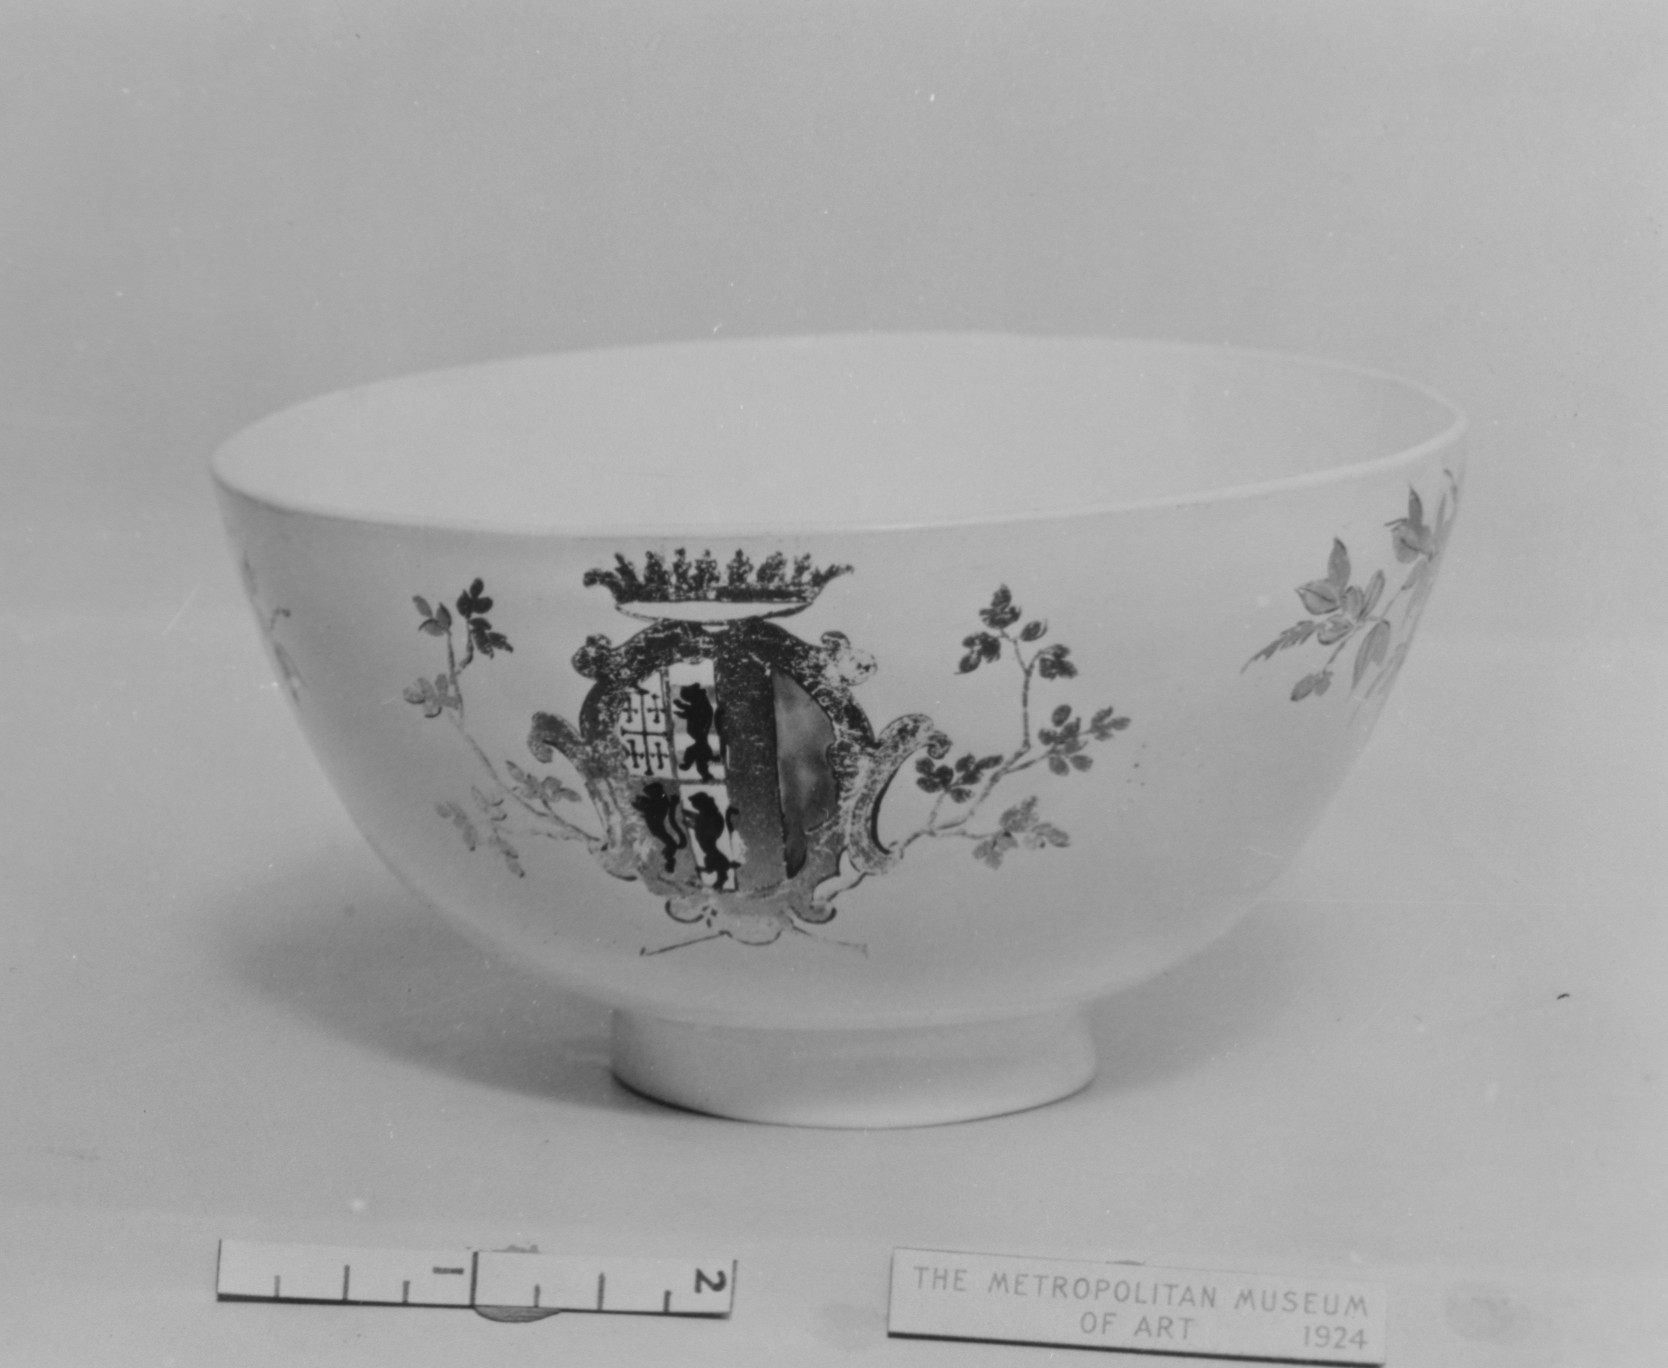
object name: bowl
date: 1701-1800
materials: glass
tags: coat of arms